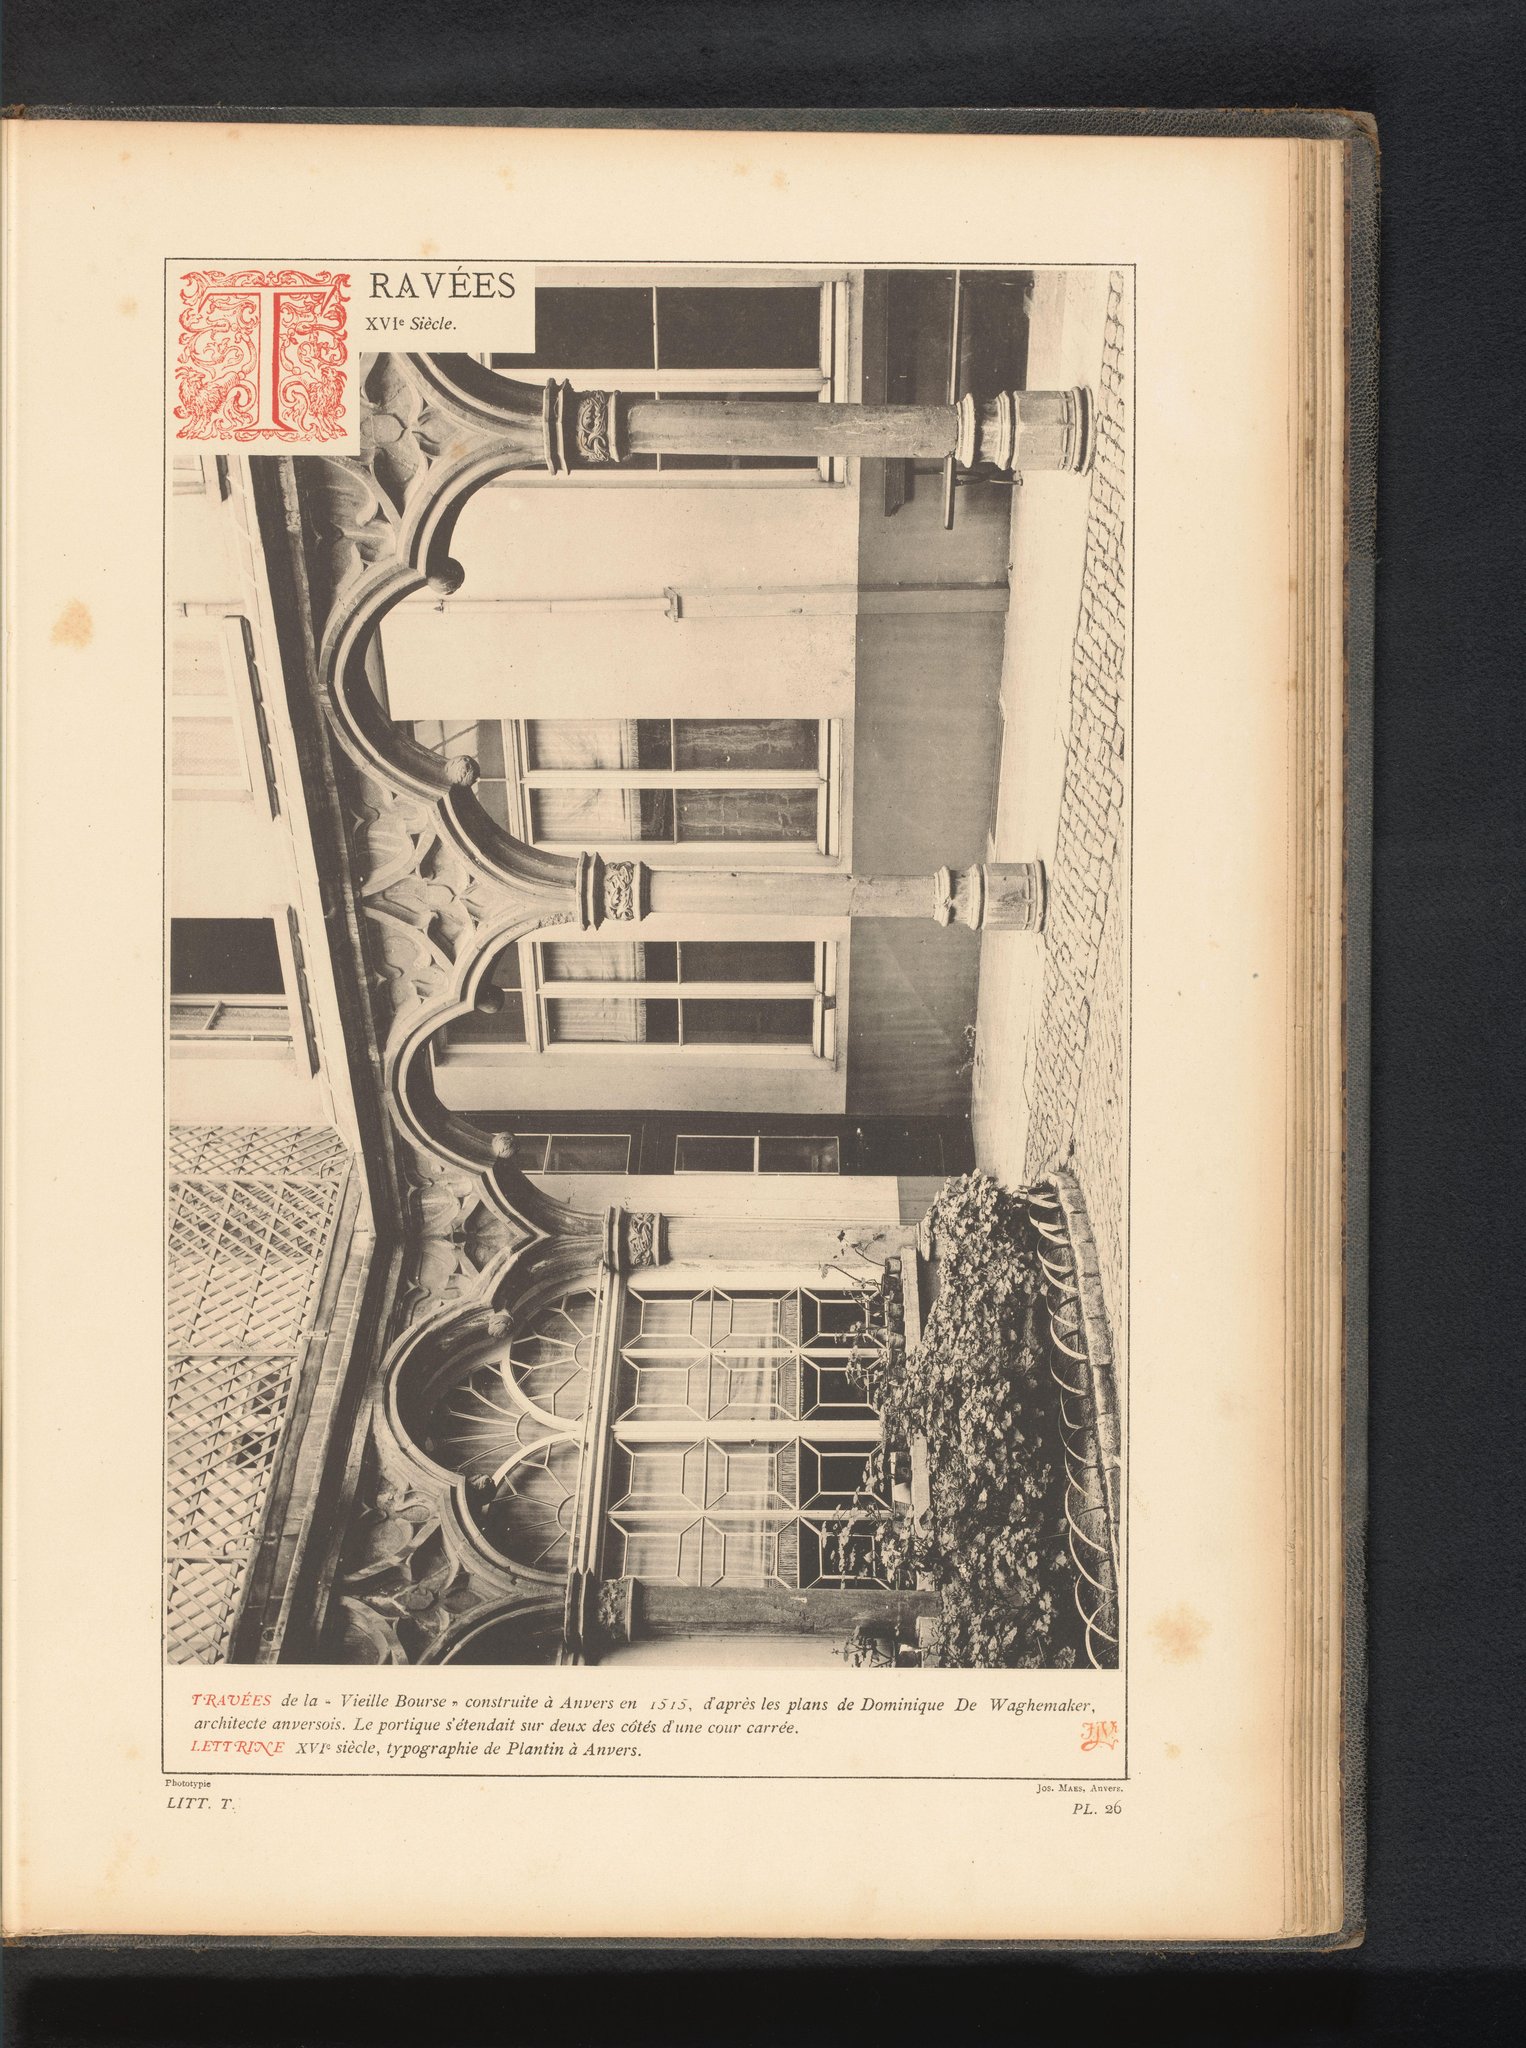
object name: page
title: Travées, XVIe Siècle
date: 1876-1881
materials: paper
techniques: photograph, photolithography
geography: antwerp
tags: civic architecture; edifices; dwellings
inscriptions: inscription: ‘LITT. T. - PL. 26.’, inscription: ‘TRAVÉES de la (...)’, monogram: ‘JJvY’